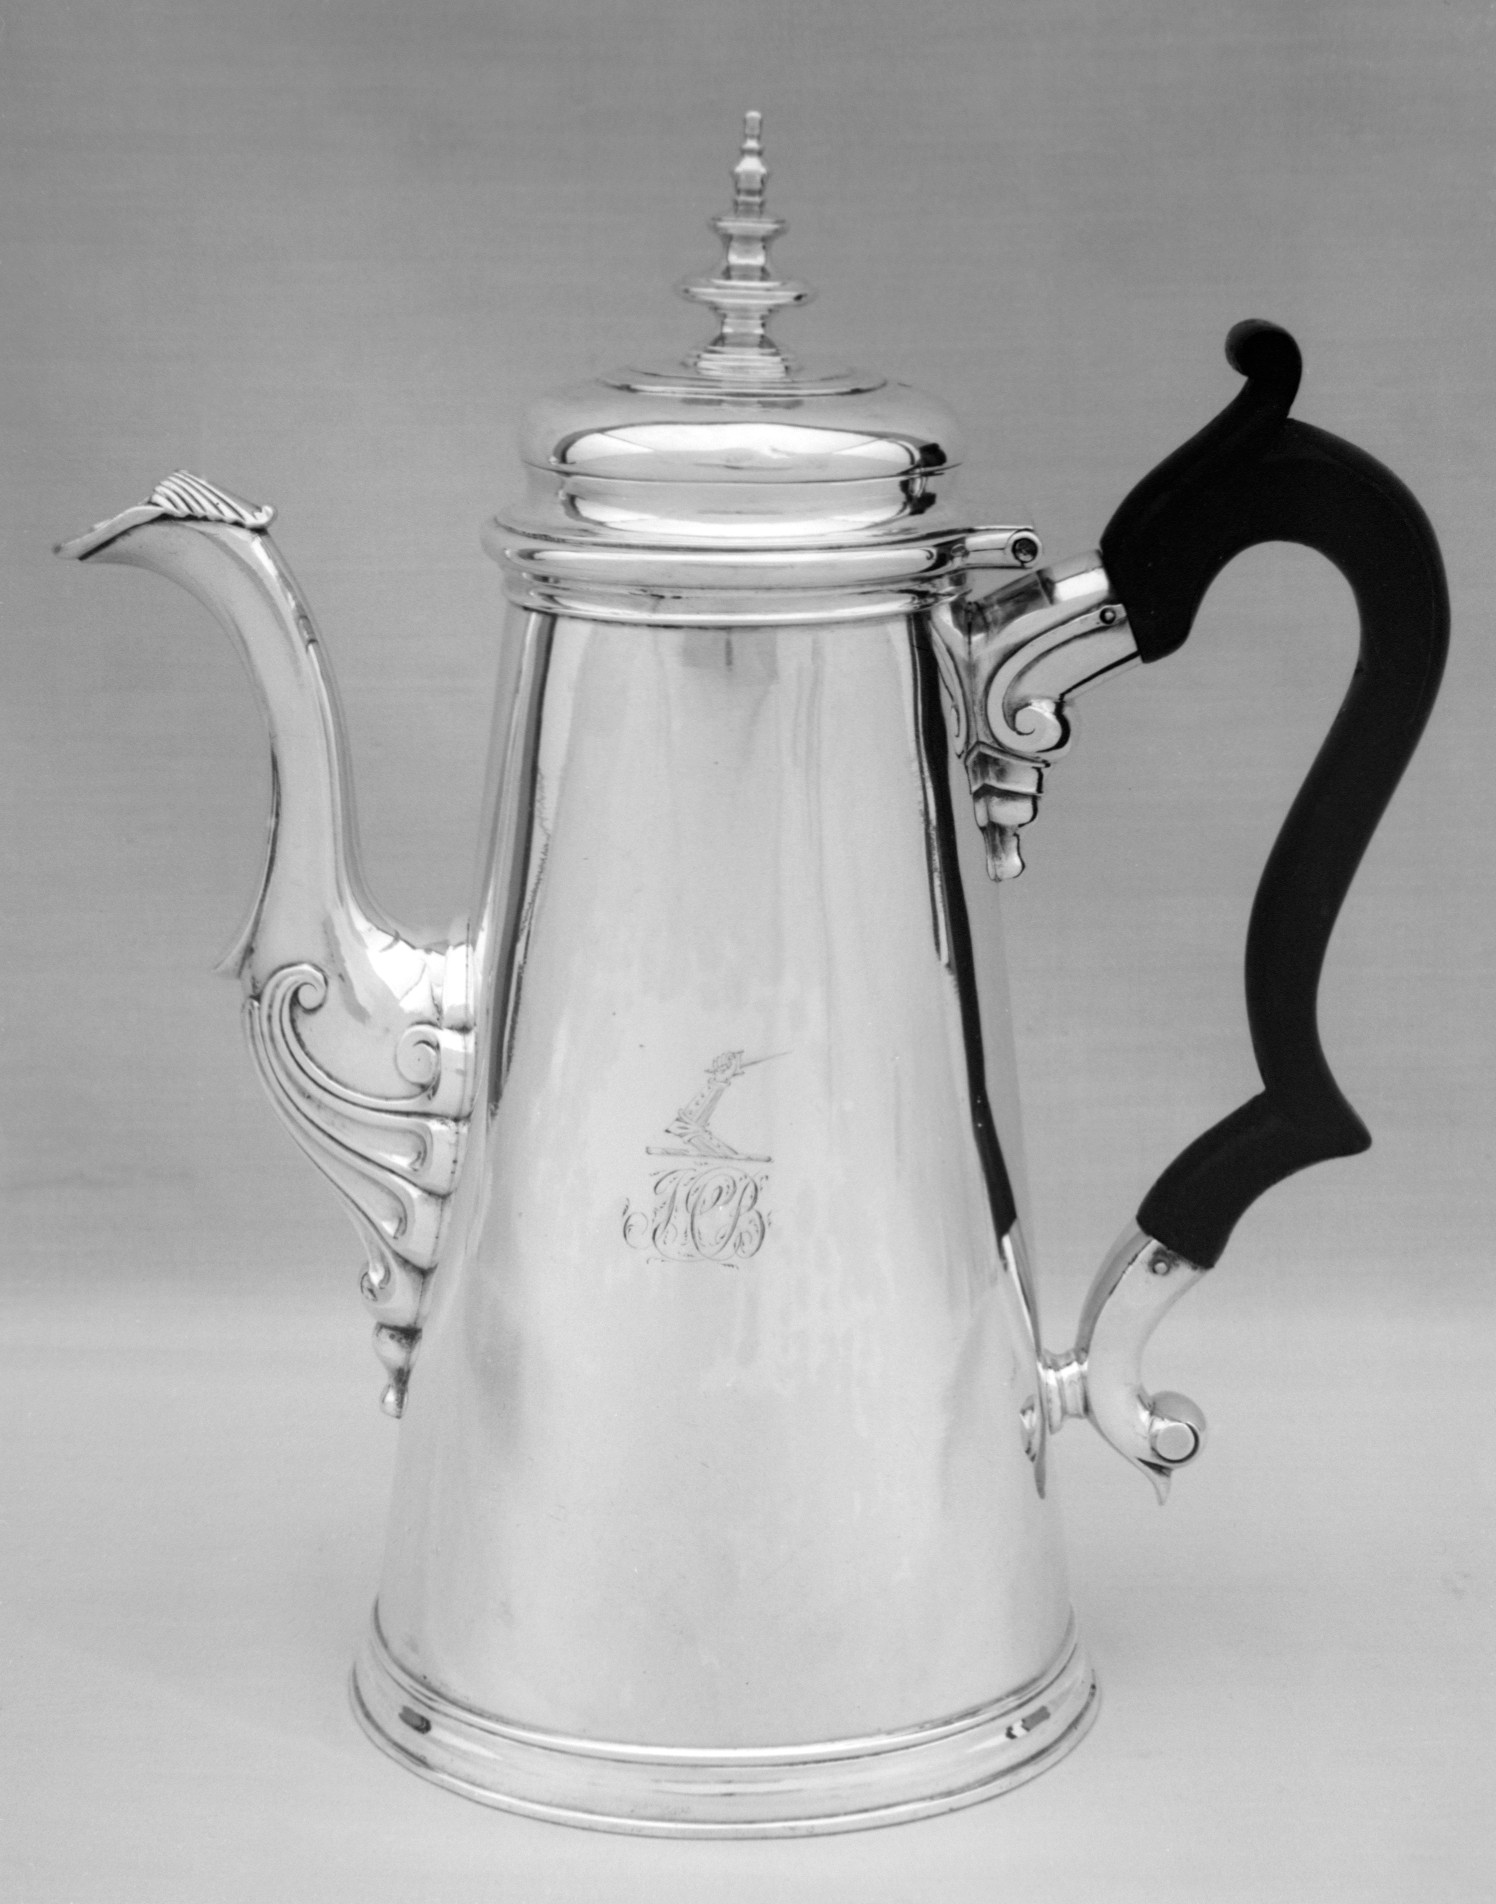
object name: coffeepot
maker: pierre amiraux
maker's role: maker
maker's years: 1726-1808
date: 1750-1770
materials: silver